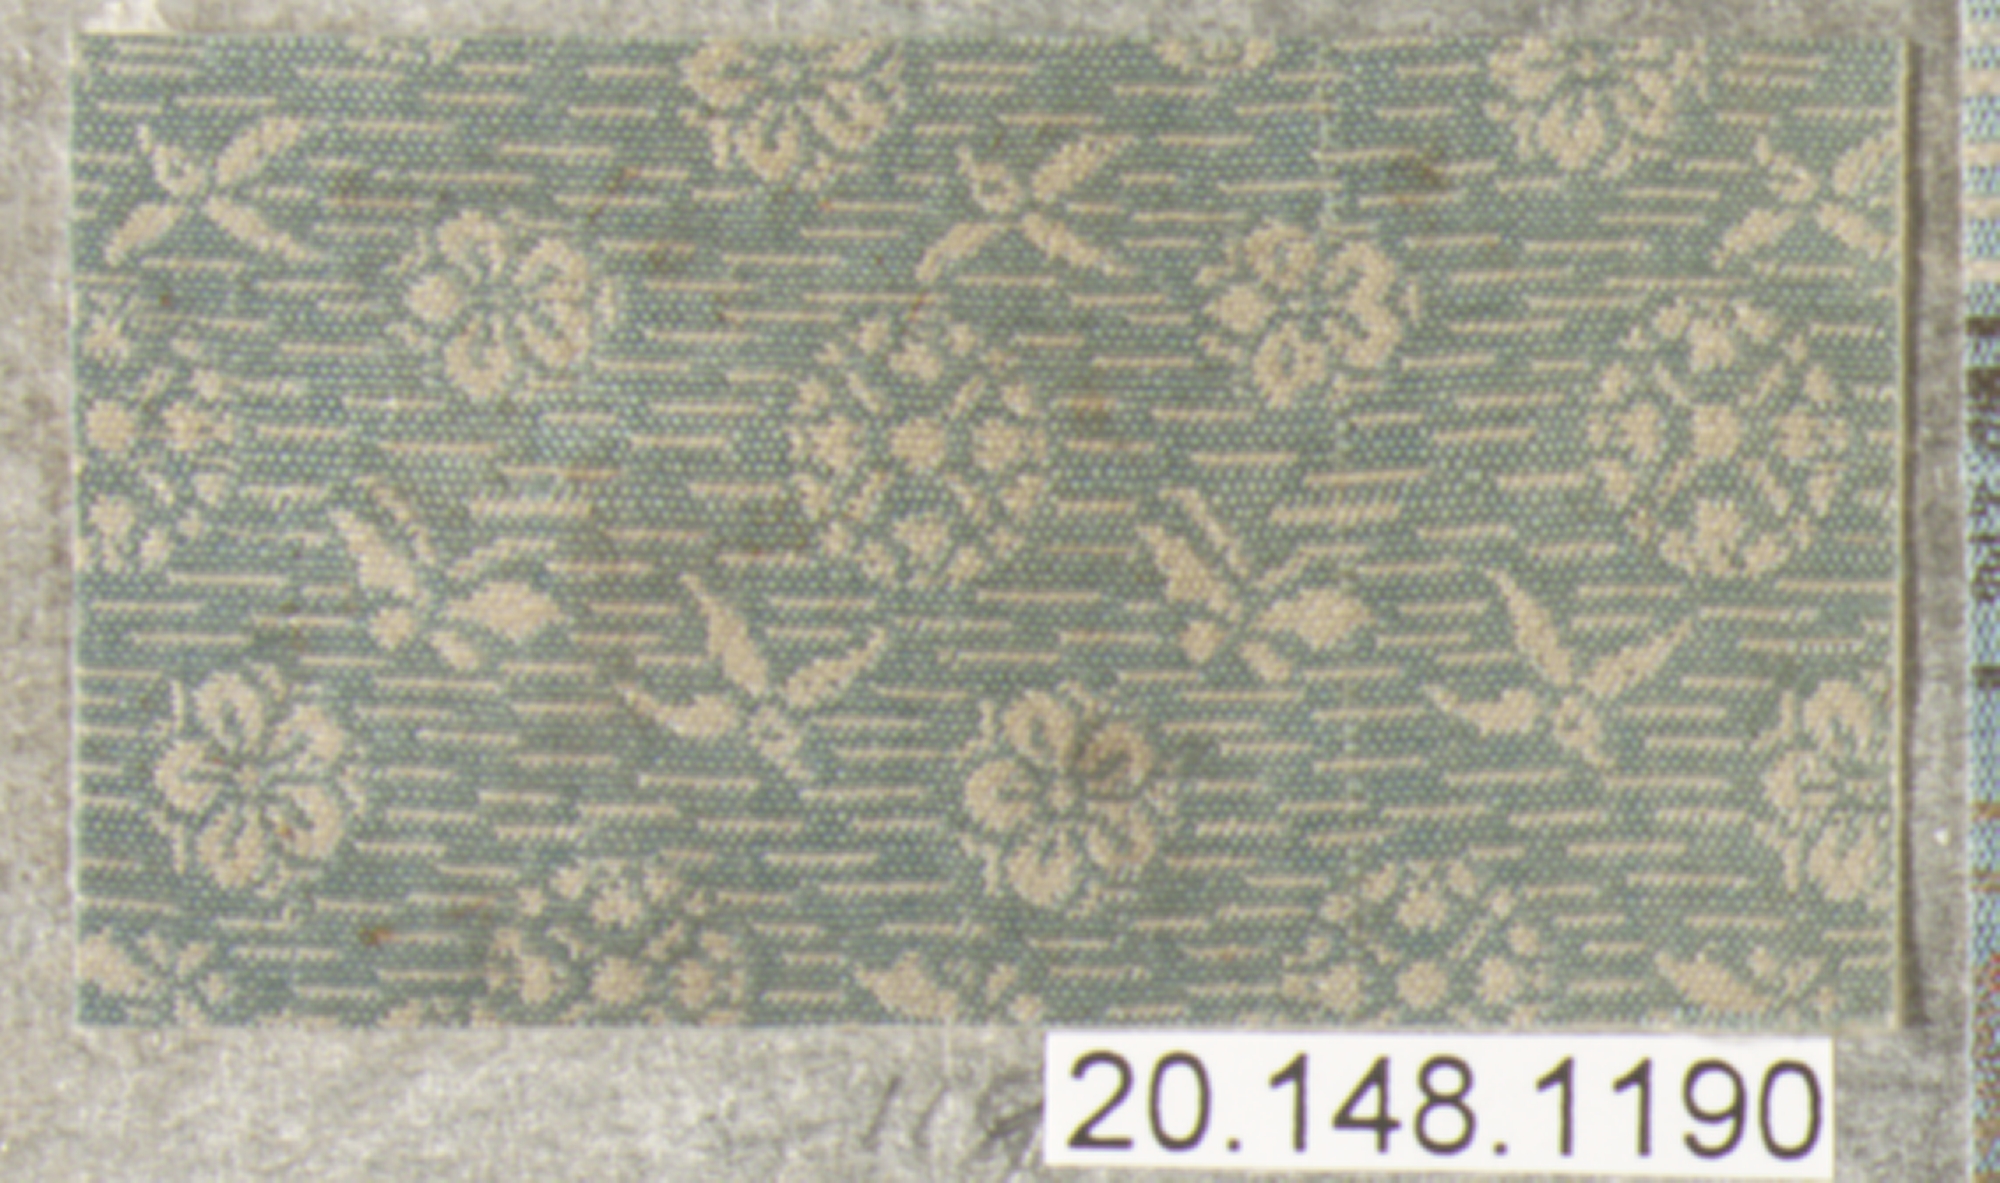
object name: piece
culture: japanese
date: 1701-1800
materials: silk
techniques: compound weave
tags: flowers